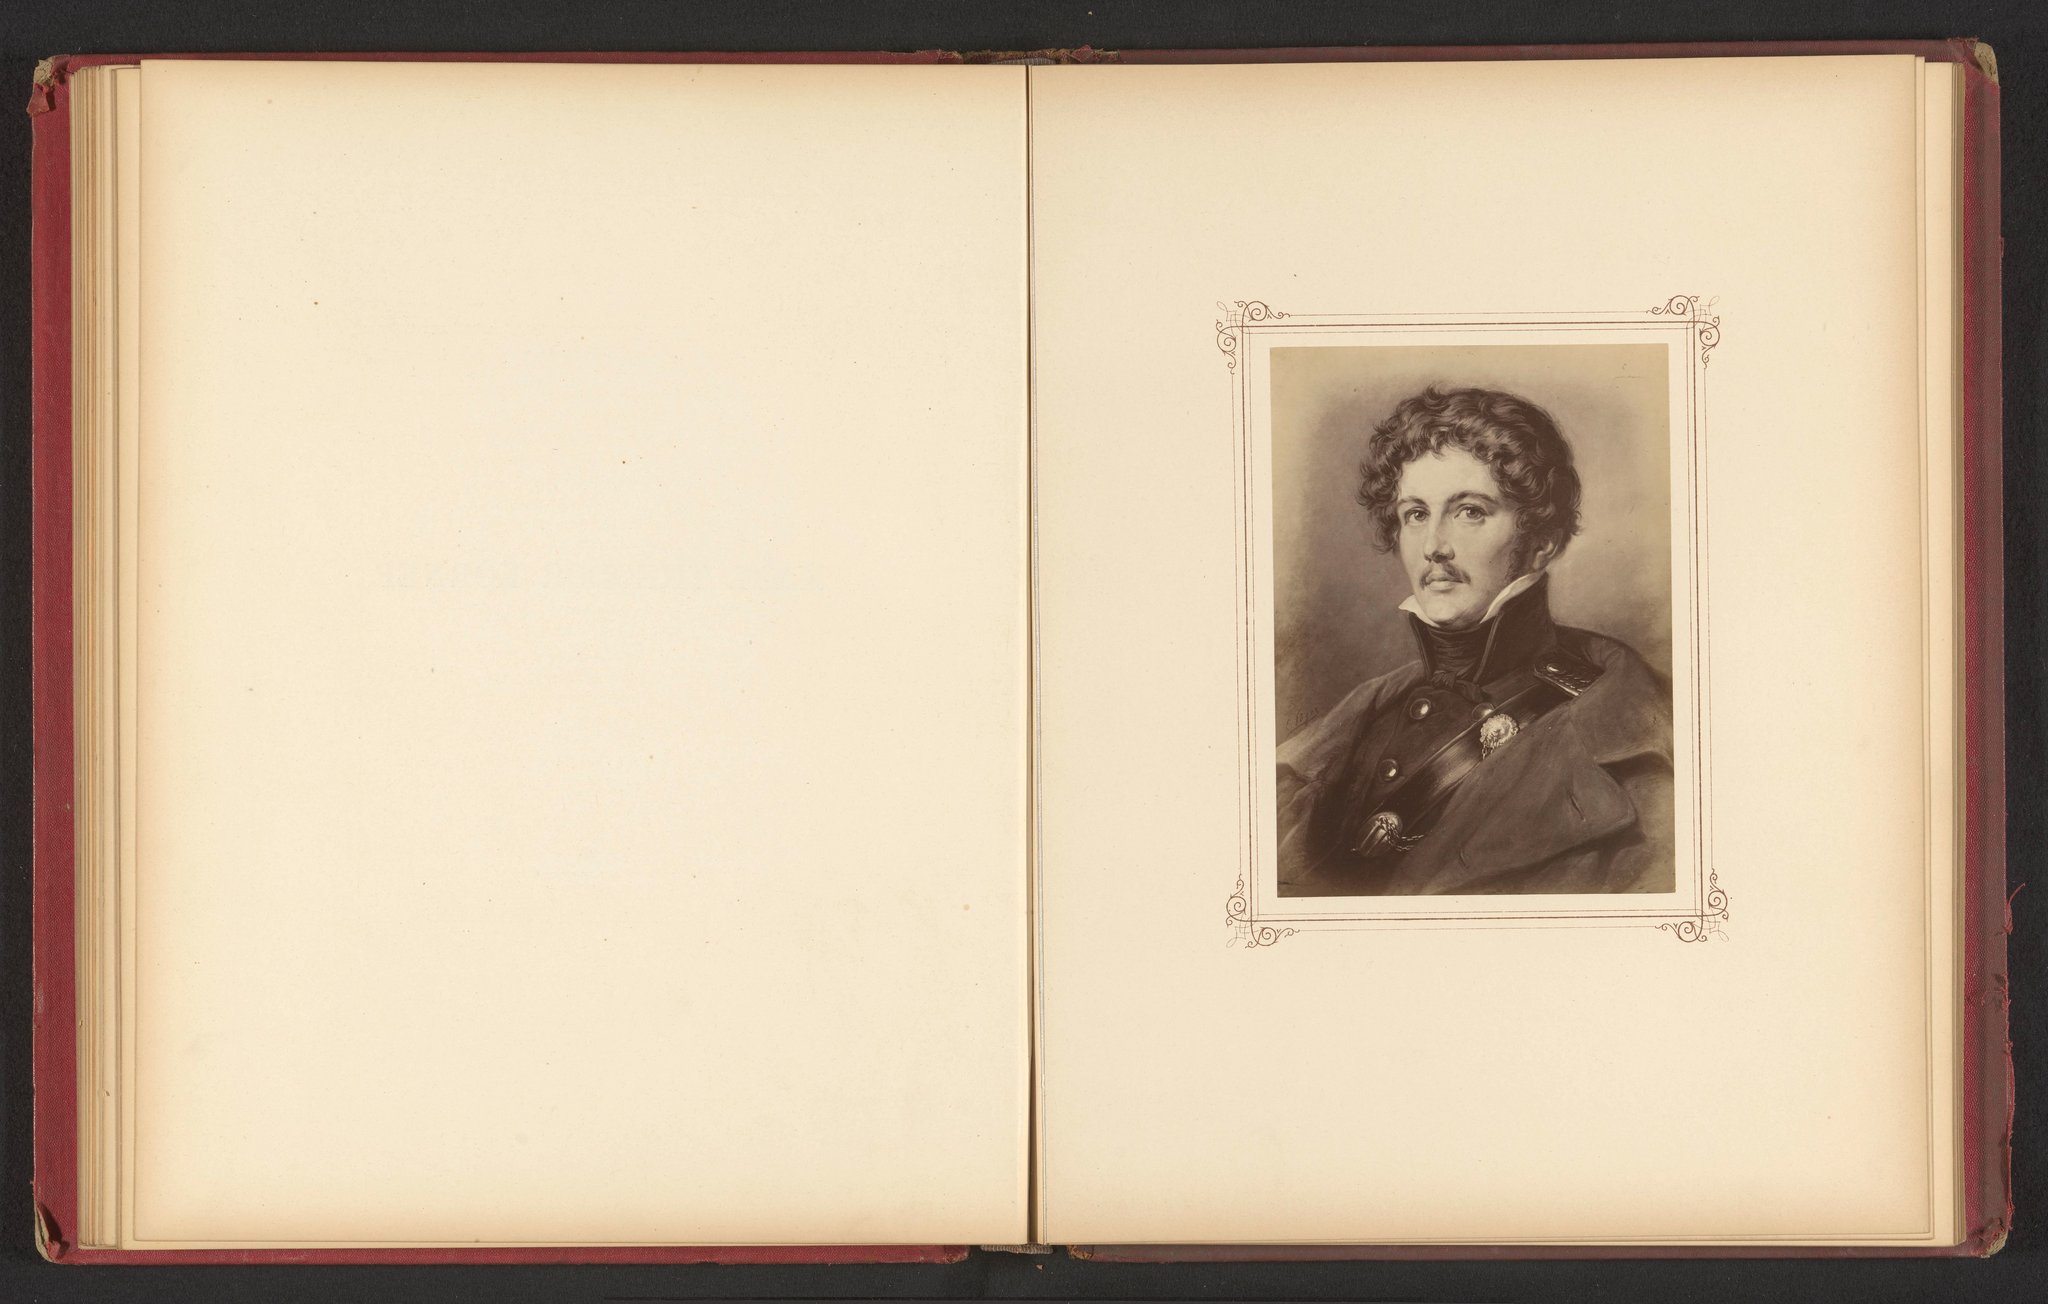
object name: page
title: Fotoreproductie van een portret van Theodor Körner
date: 1868-1878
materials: photographic support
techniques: albumen print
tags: writer, poet, author